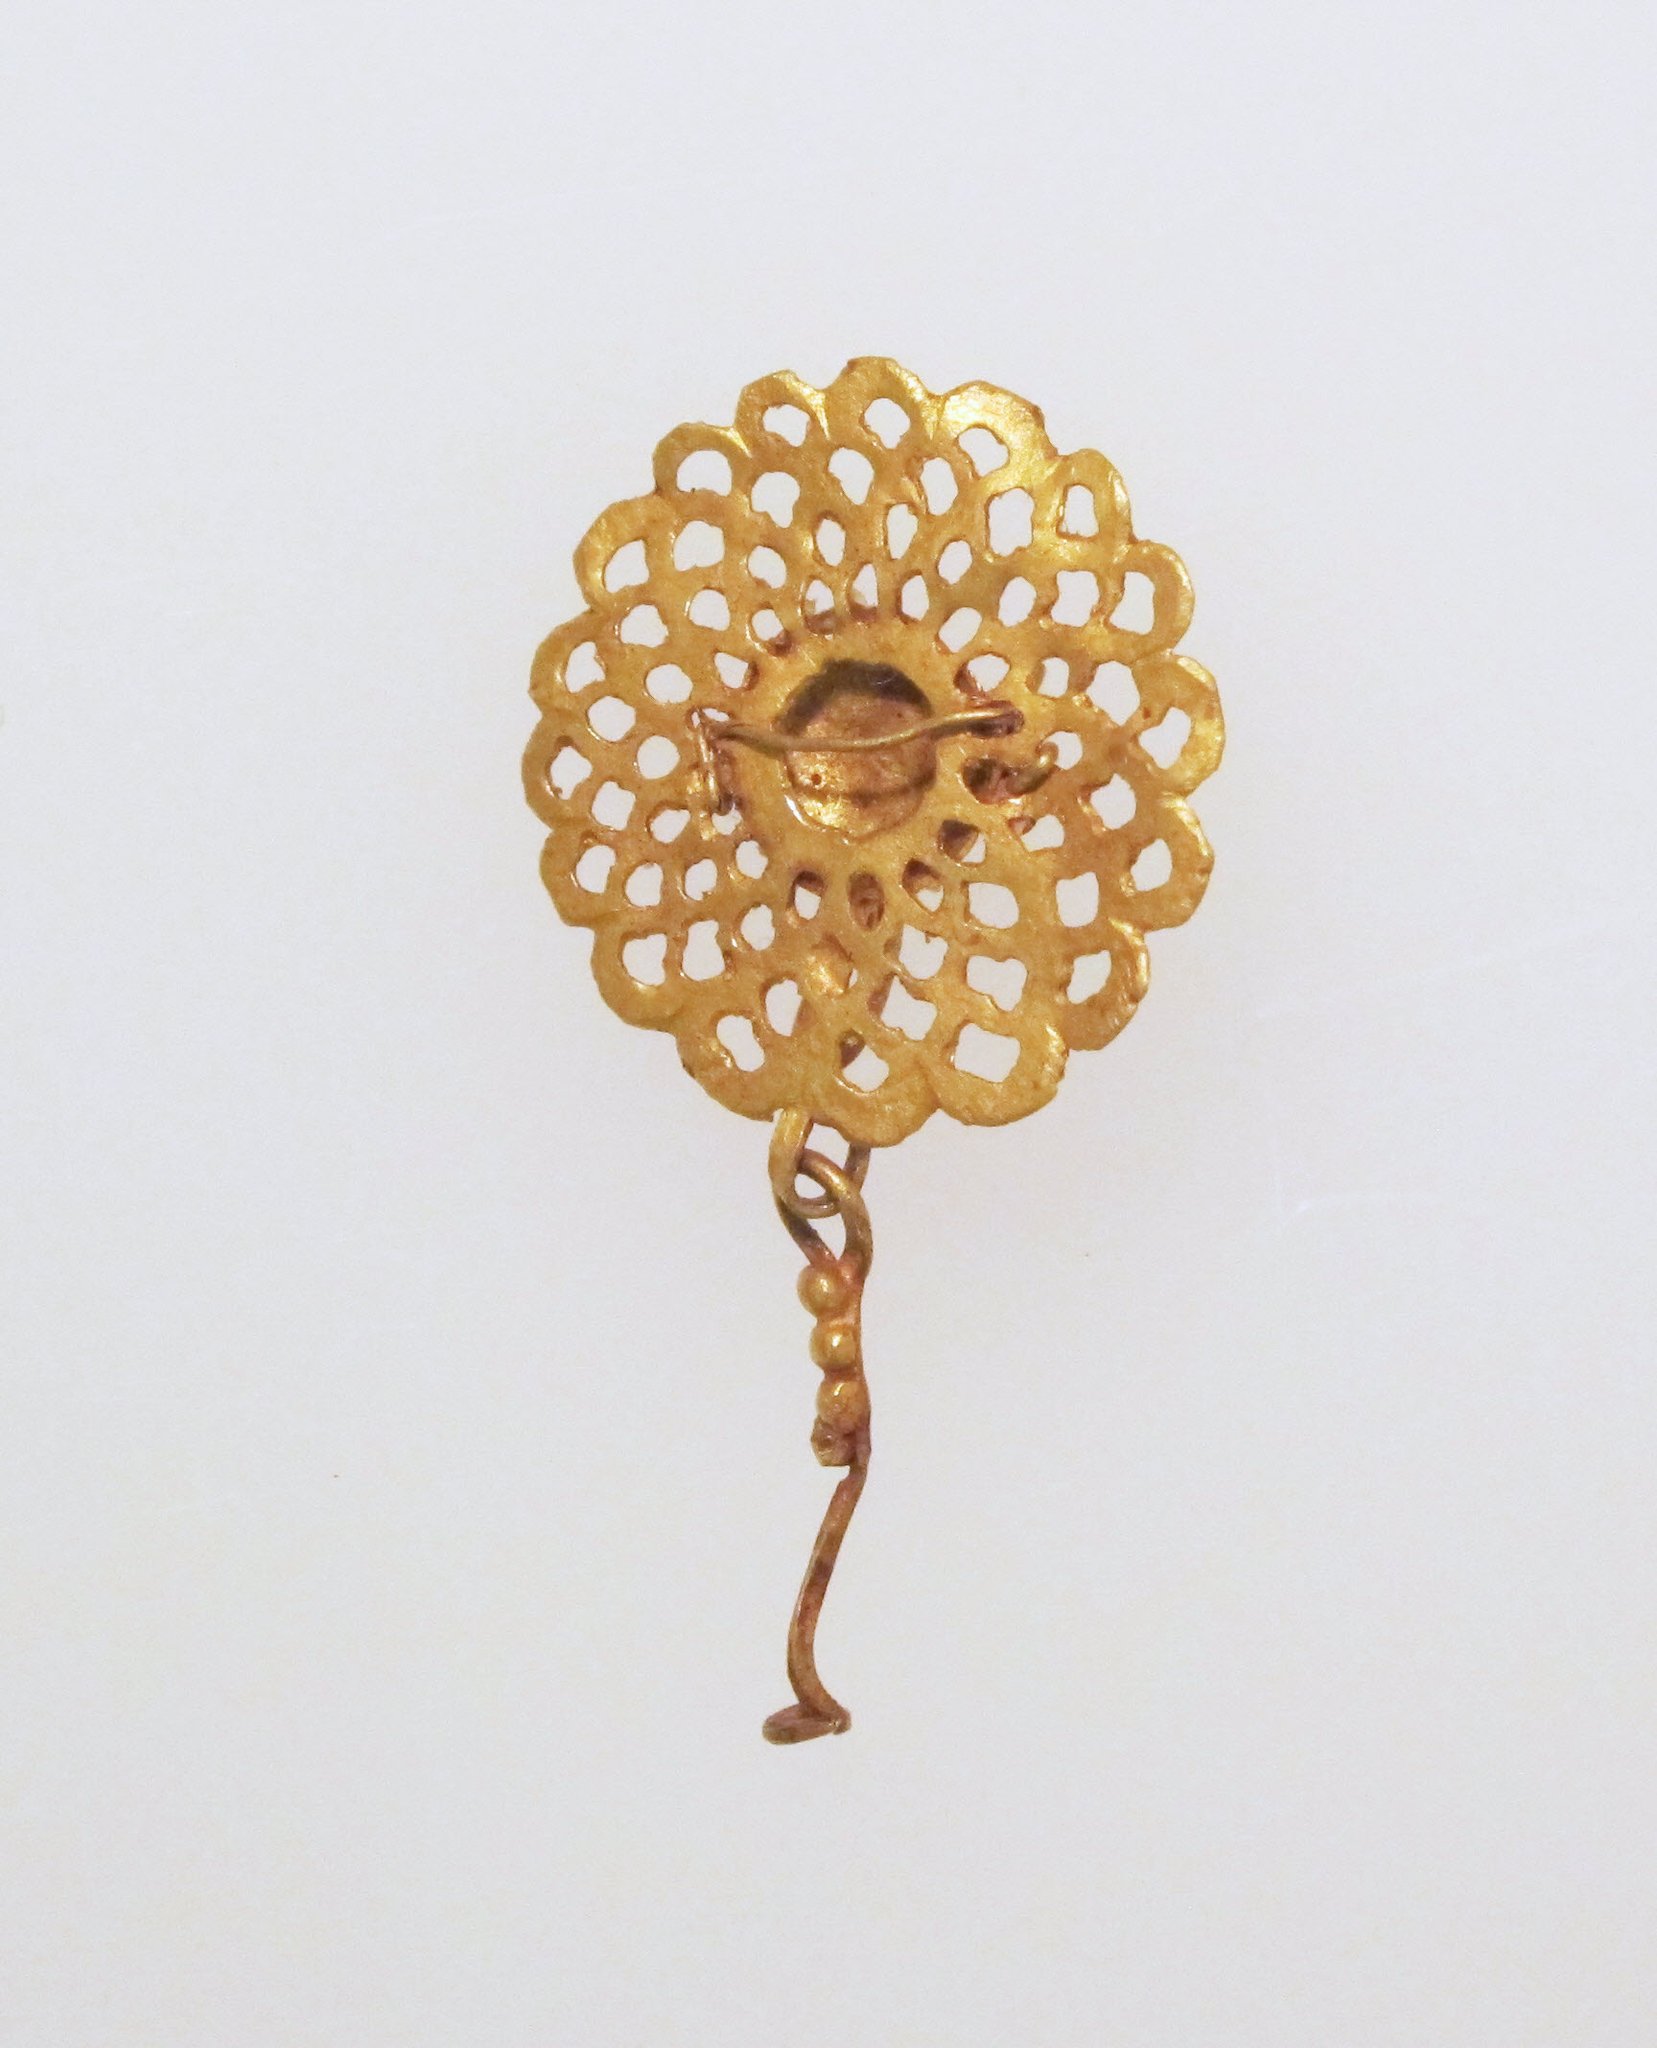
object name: earring hook type with pendant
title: Gold earring with rosette disk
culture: roman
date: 201-300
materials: gold